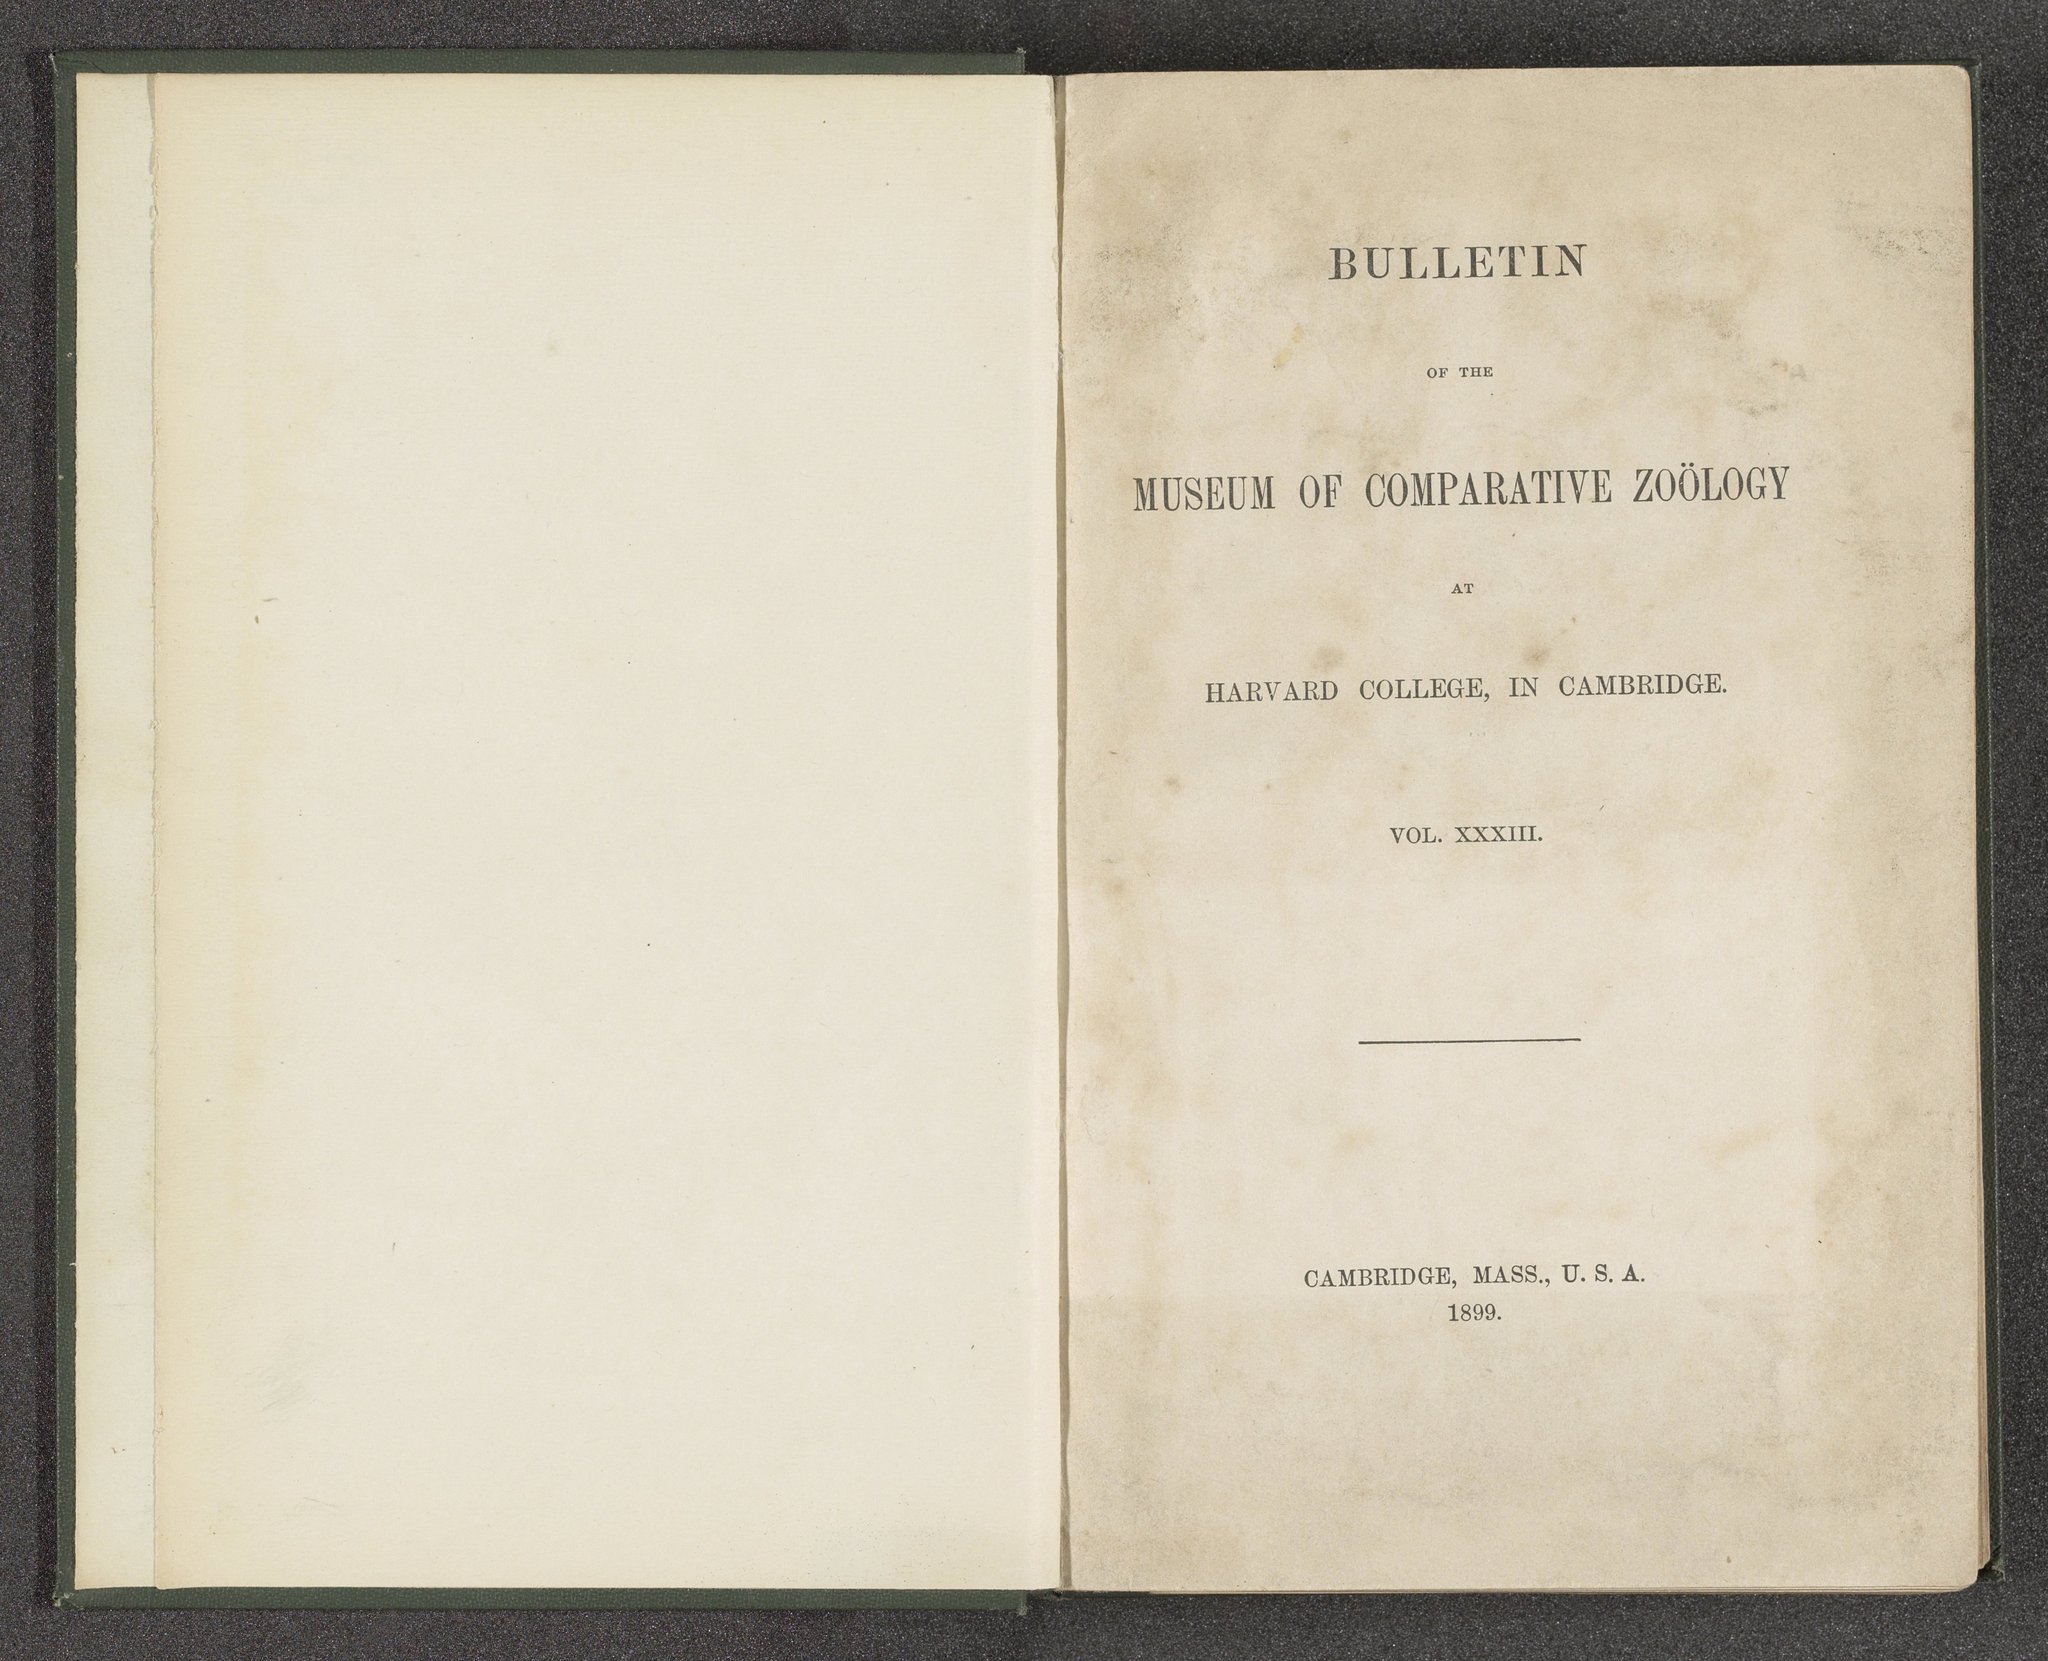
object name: book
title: The islands and coral reefs of Fiji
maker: alexander agassiz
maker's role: engineer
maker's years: 1835-1910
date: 1899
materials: cardboard, linen, paper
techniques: photograph, lithograph, printing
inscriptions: name: ‘Charpenter & Co. Stationers, Booksellers, & Printers. High Street, Portsmouth’